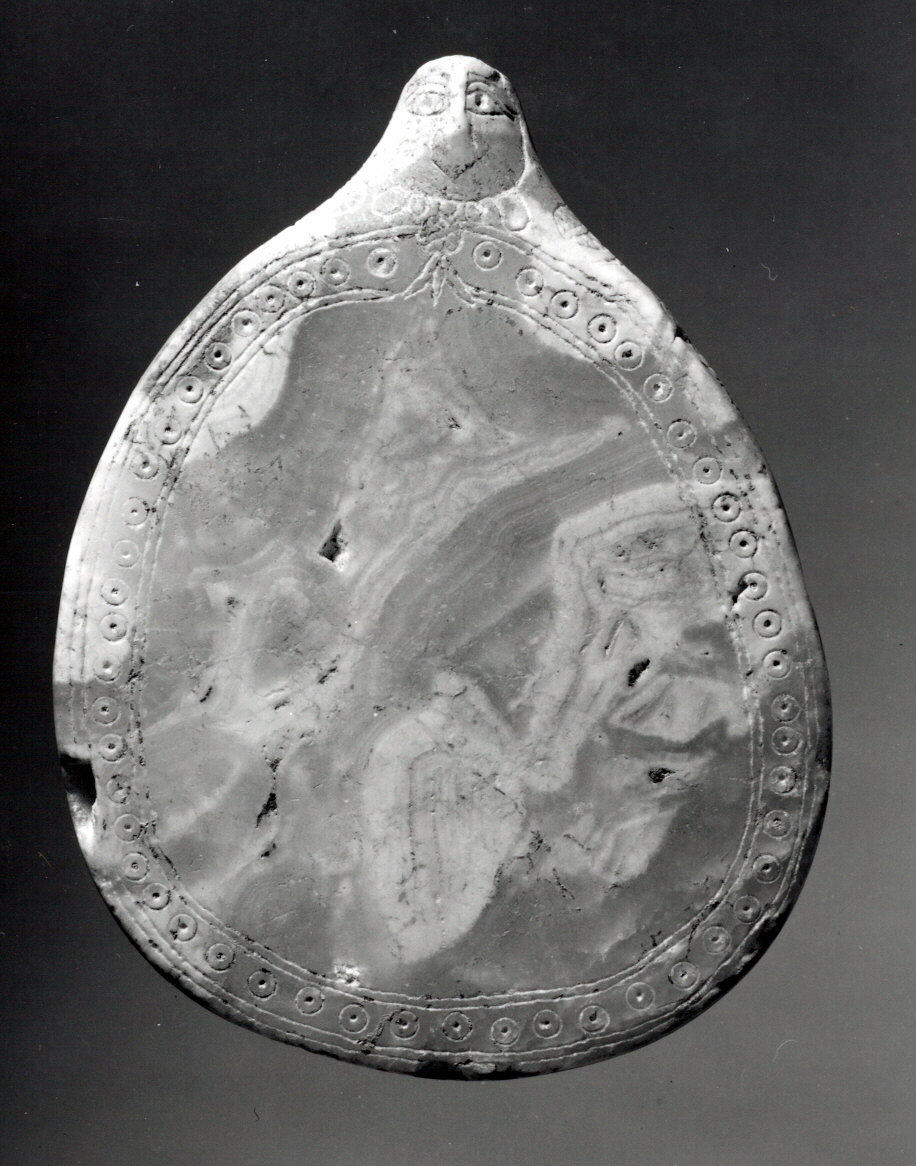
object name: palette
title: Palette with a sculpted female head and incised decoration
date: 700-601 BCE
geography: levant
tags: heads